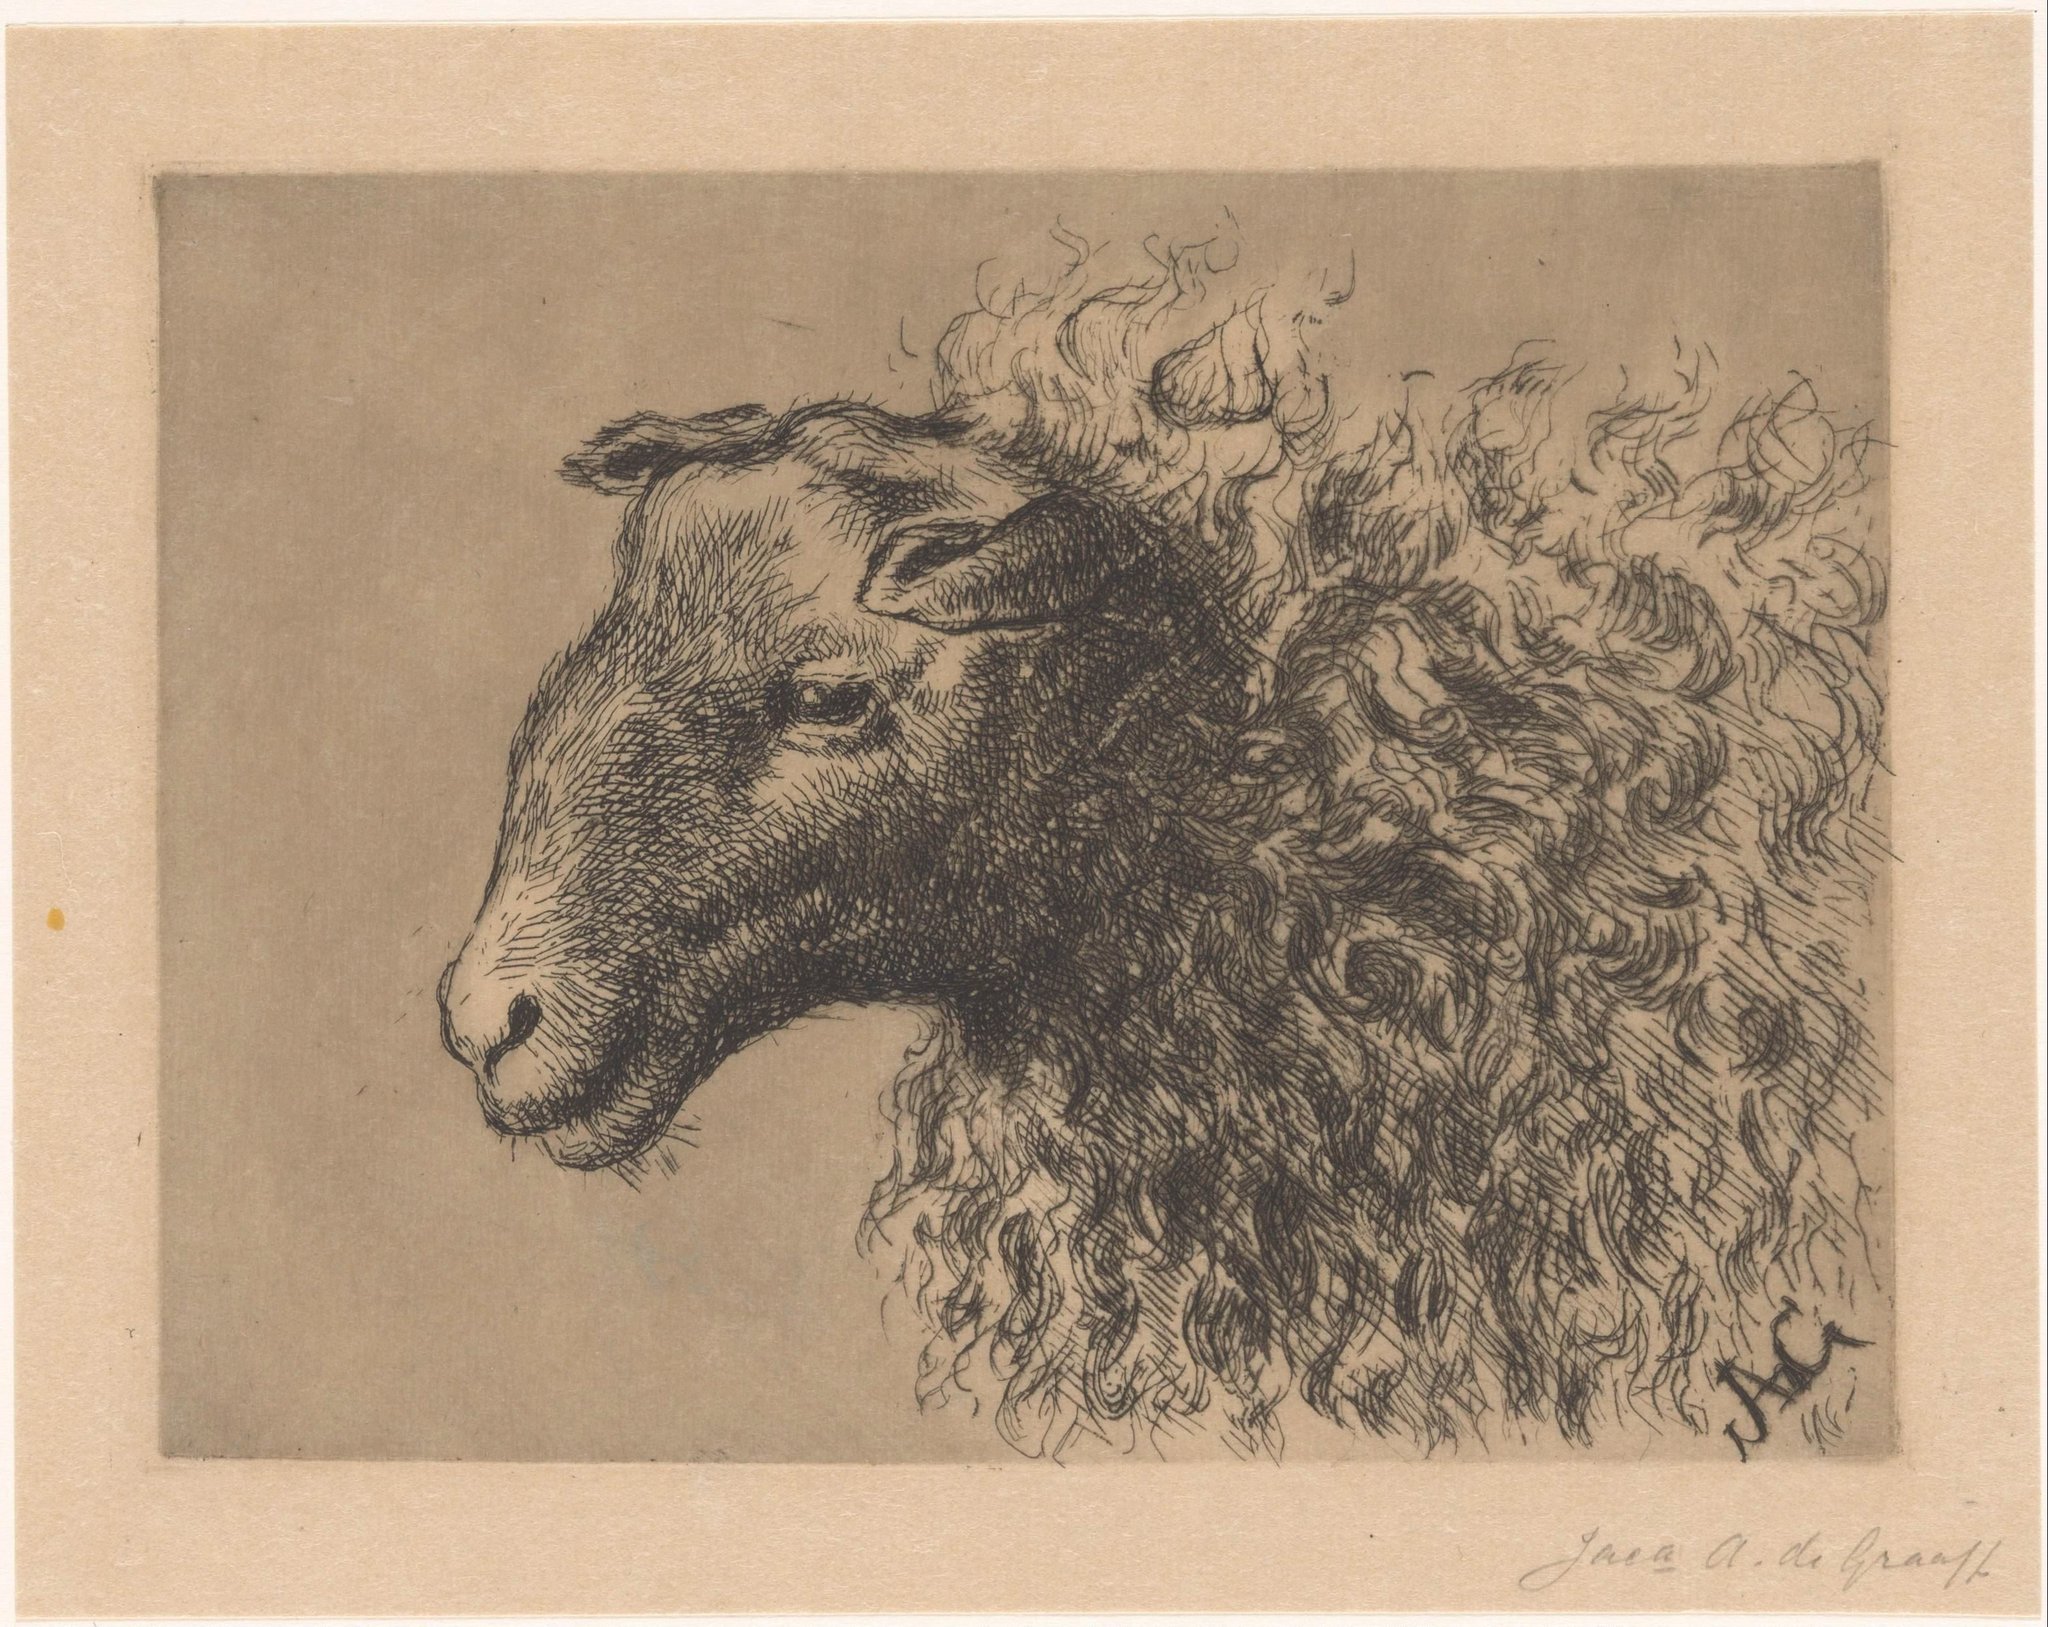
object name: print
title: Schaap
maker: jacoba de graaff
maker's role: print maker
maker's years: 1857-1940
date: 1867-1911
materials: paper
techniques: etching, intaglio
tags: sheep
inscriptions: collector's mark: Lugt 2228